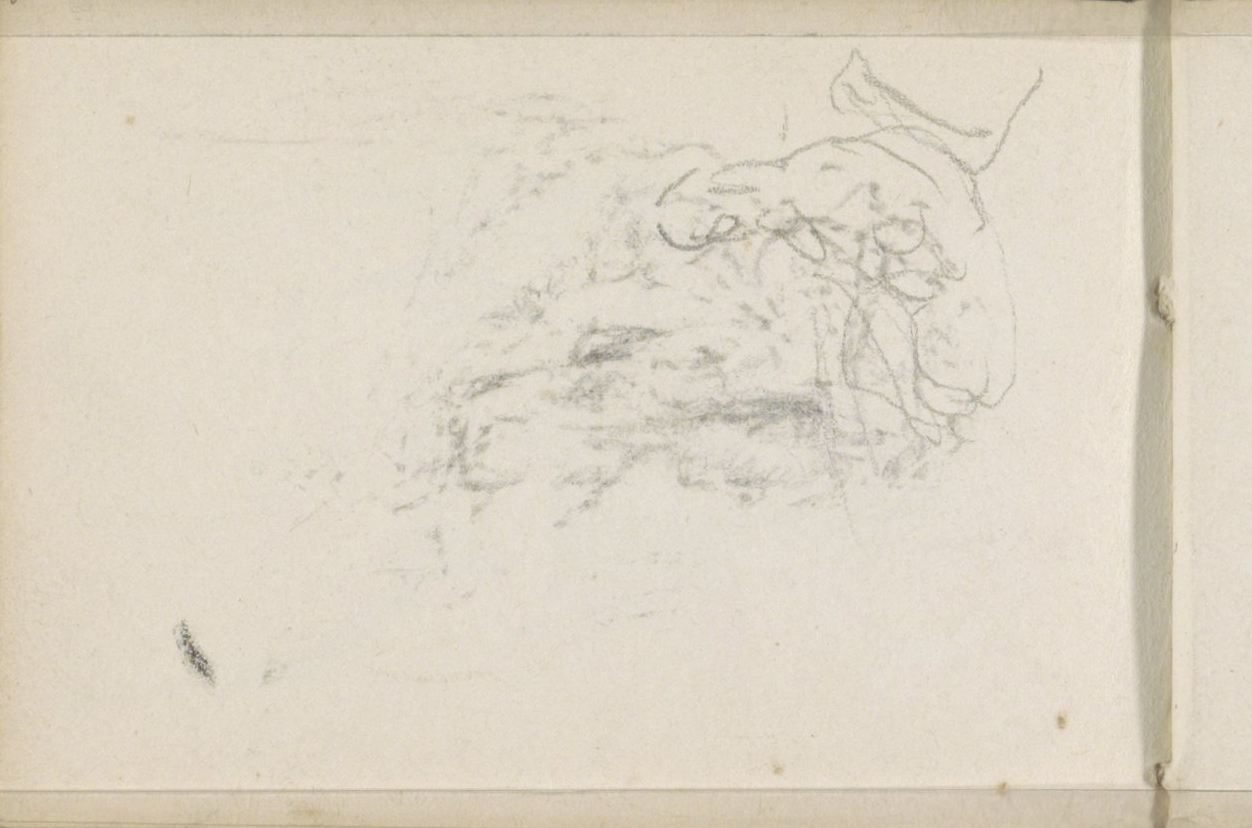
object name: sketchbook leaf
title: Zittende figuur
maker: marius bauer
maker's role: draughtsman, print maker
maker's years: 1867-1932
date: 1922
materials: paper, pencil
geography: biskra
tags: africans, adult man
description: De figuur draagt een lang gewaad en sluier om het hoofd. Pagina 6 uit een schetsboek met 32 bladen.